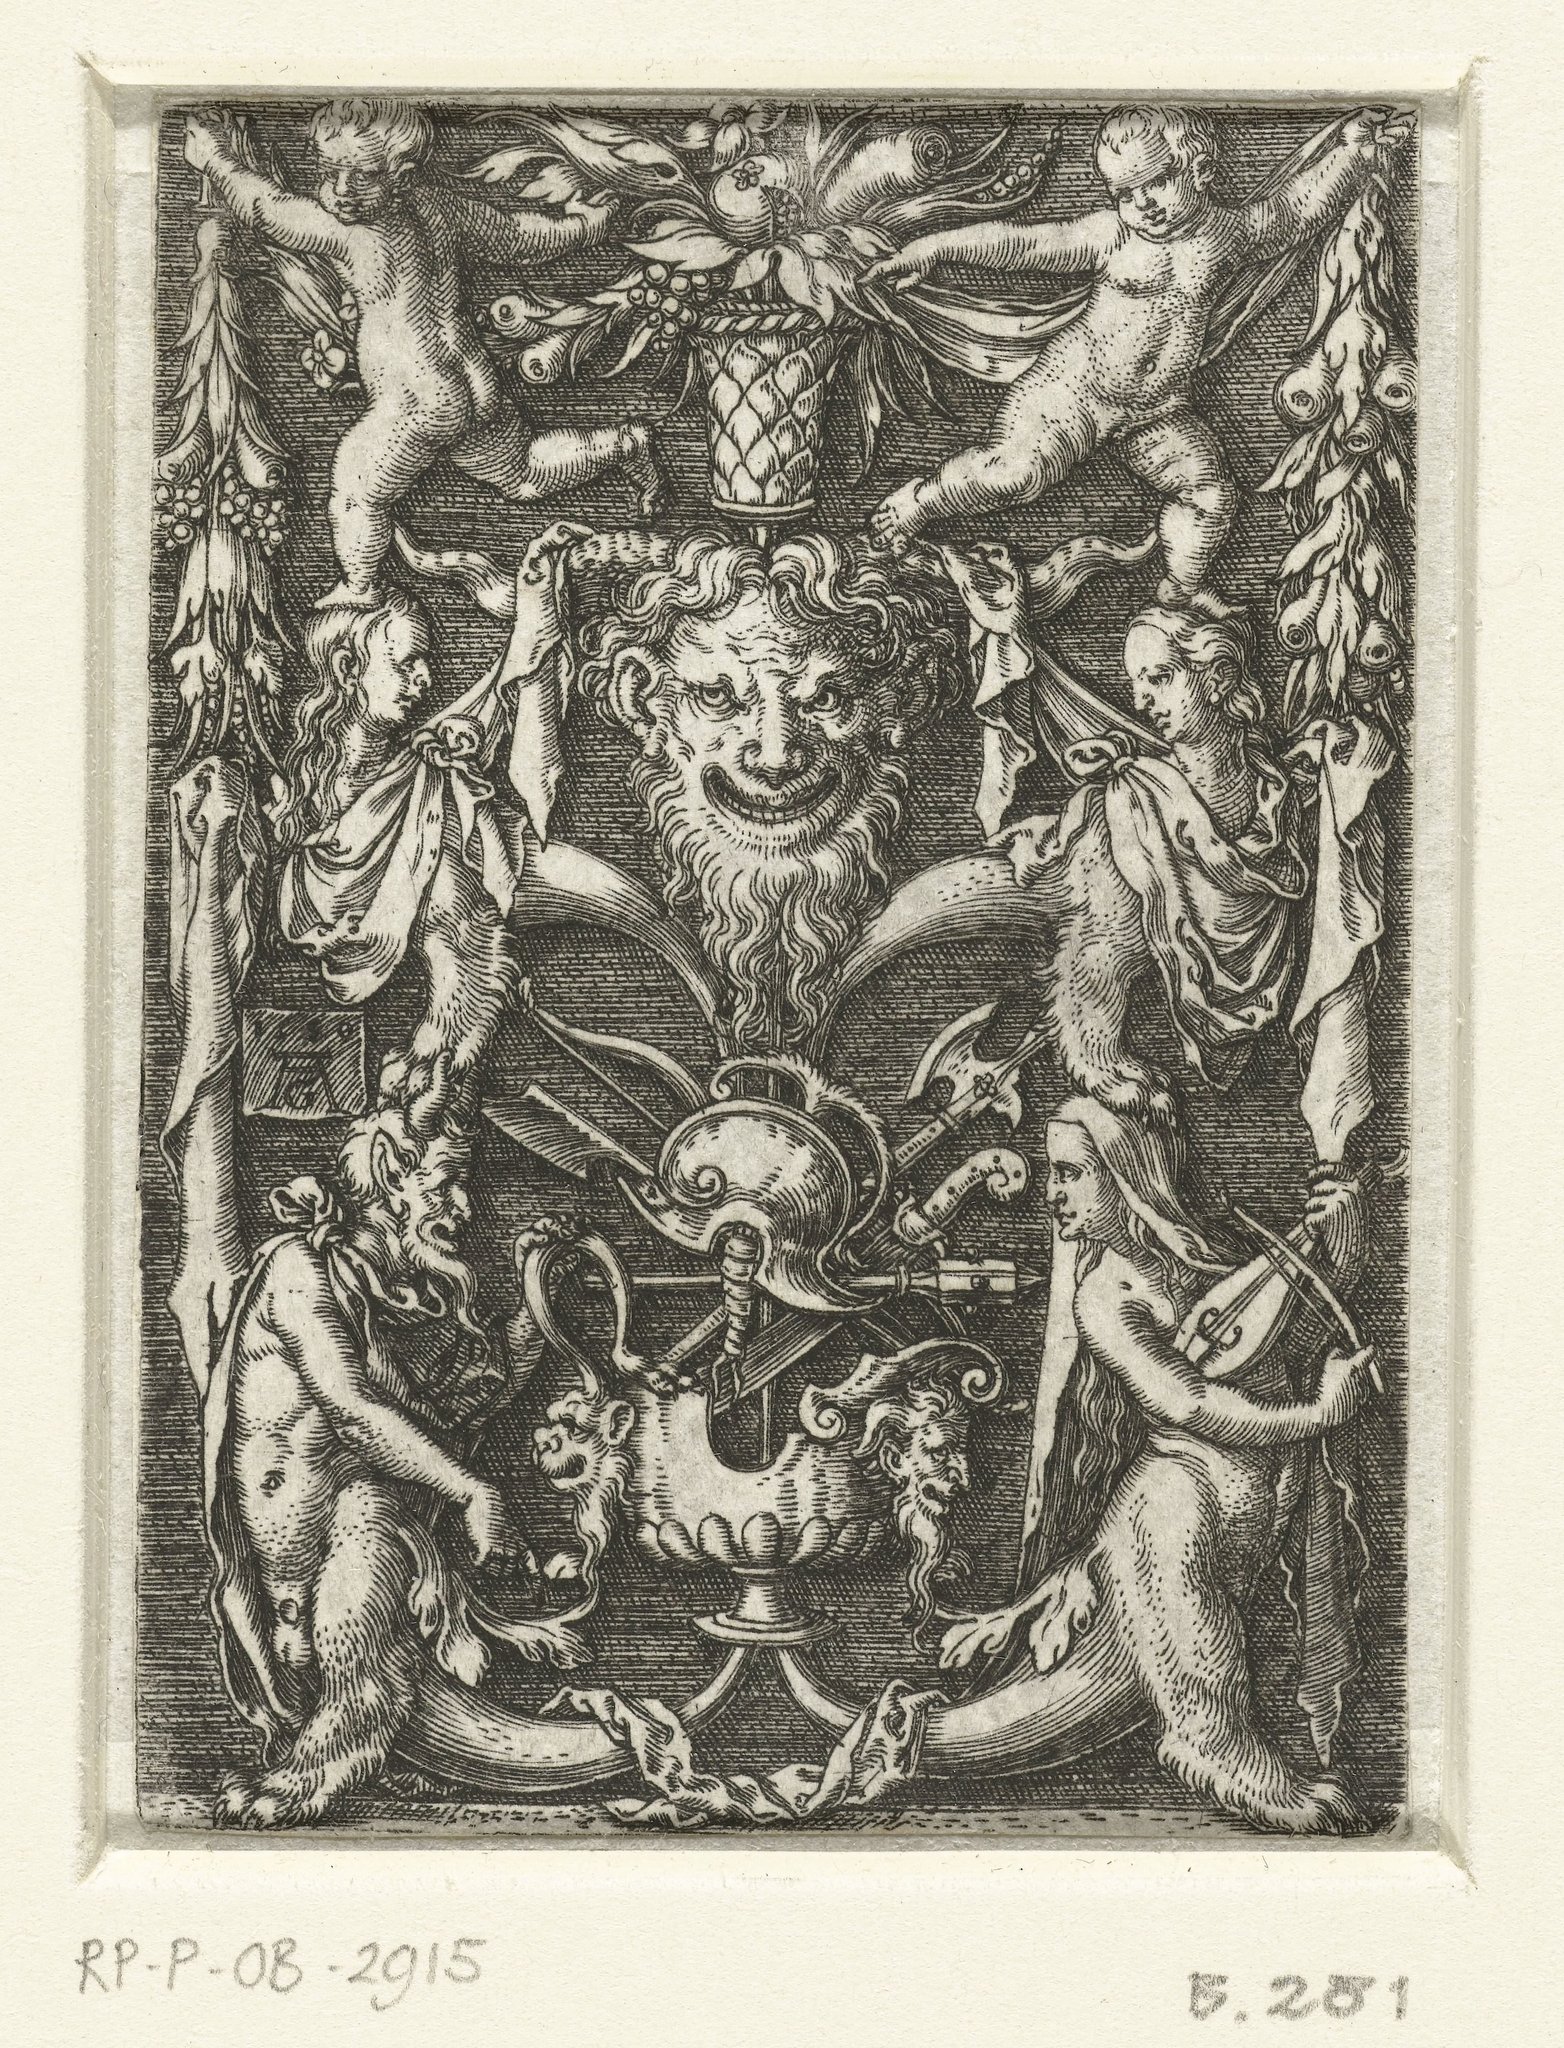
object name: ornament print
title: Vlakdecoratie met grotesken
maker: heinrich aldegrever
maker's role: draughtsman, print maker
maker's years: 1502-1561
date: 1550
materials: paper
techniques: engraving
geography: germany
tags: ornaments ~ art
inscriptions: number: ‘23’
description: Vlakdecoratie met onderaan een wapentrofee in een vaas. Uit de voet van devaas komen twee hoorns die uitlopen in het bovenlichaam van een sater en een vedelspelende vrouw. Zij dragen elk op hun hoofd een vrouwelijk figuur, die op haar beurt weer een kind op haar hoofd heeft staan. In het midden het hoofd van een sater.